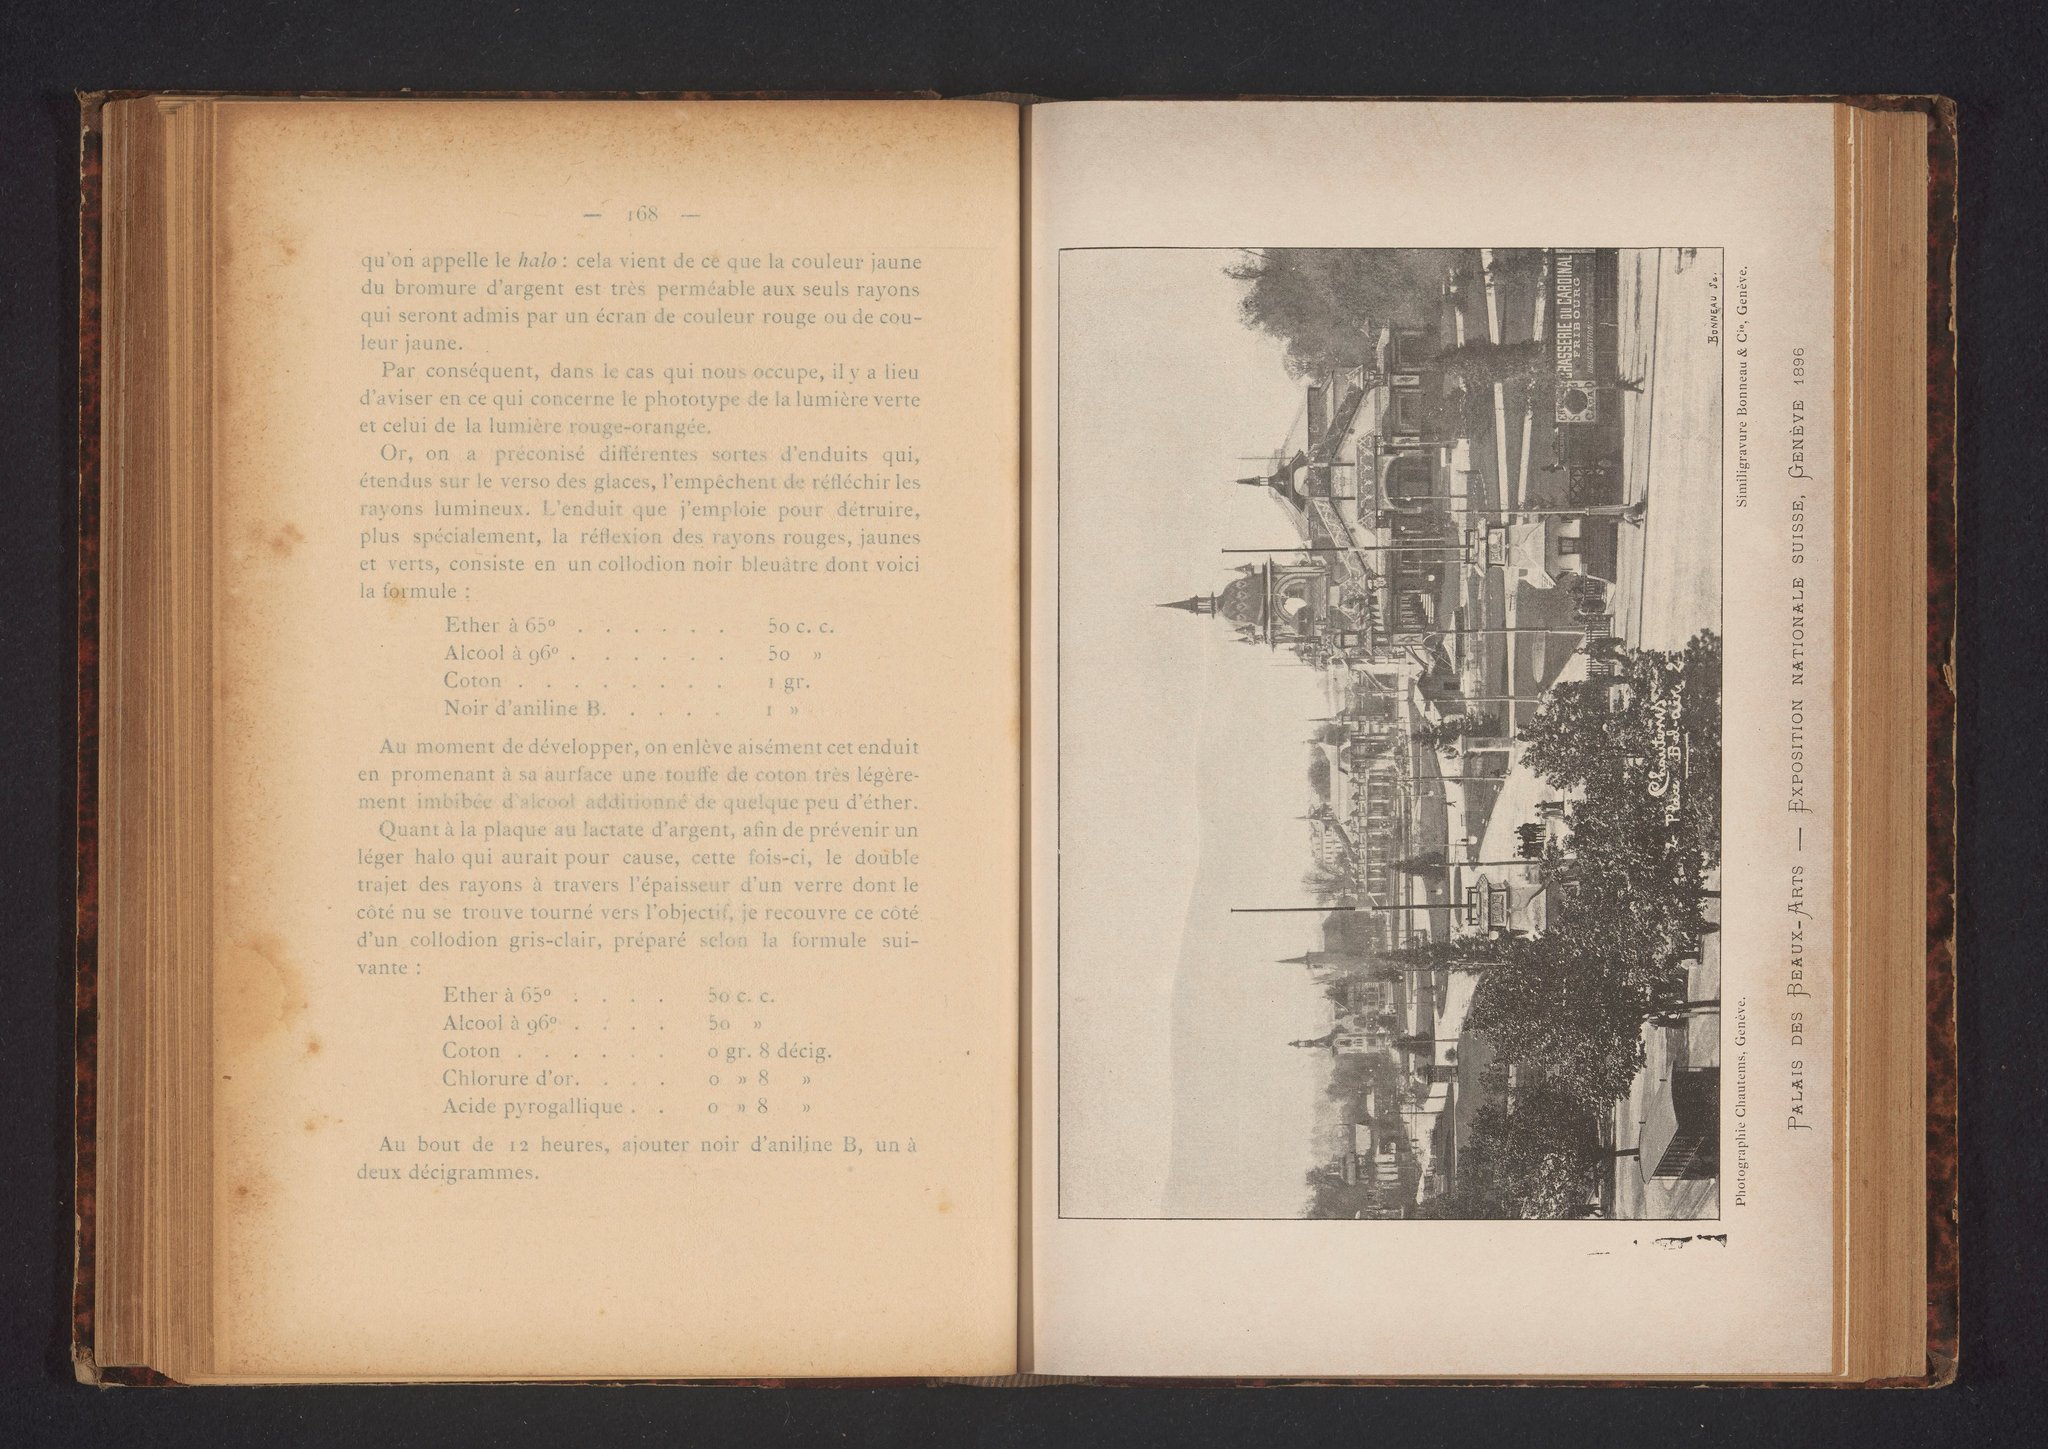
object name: photomechanical print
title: Palais des Beaux-Arts - Exposition nationals suisse, Genève 1896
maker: chautems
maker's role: fotograaf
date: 1896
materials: paper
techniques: autotype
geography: geneva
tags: palace, permanent exhibition, museum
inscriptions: date